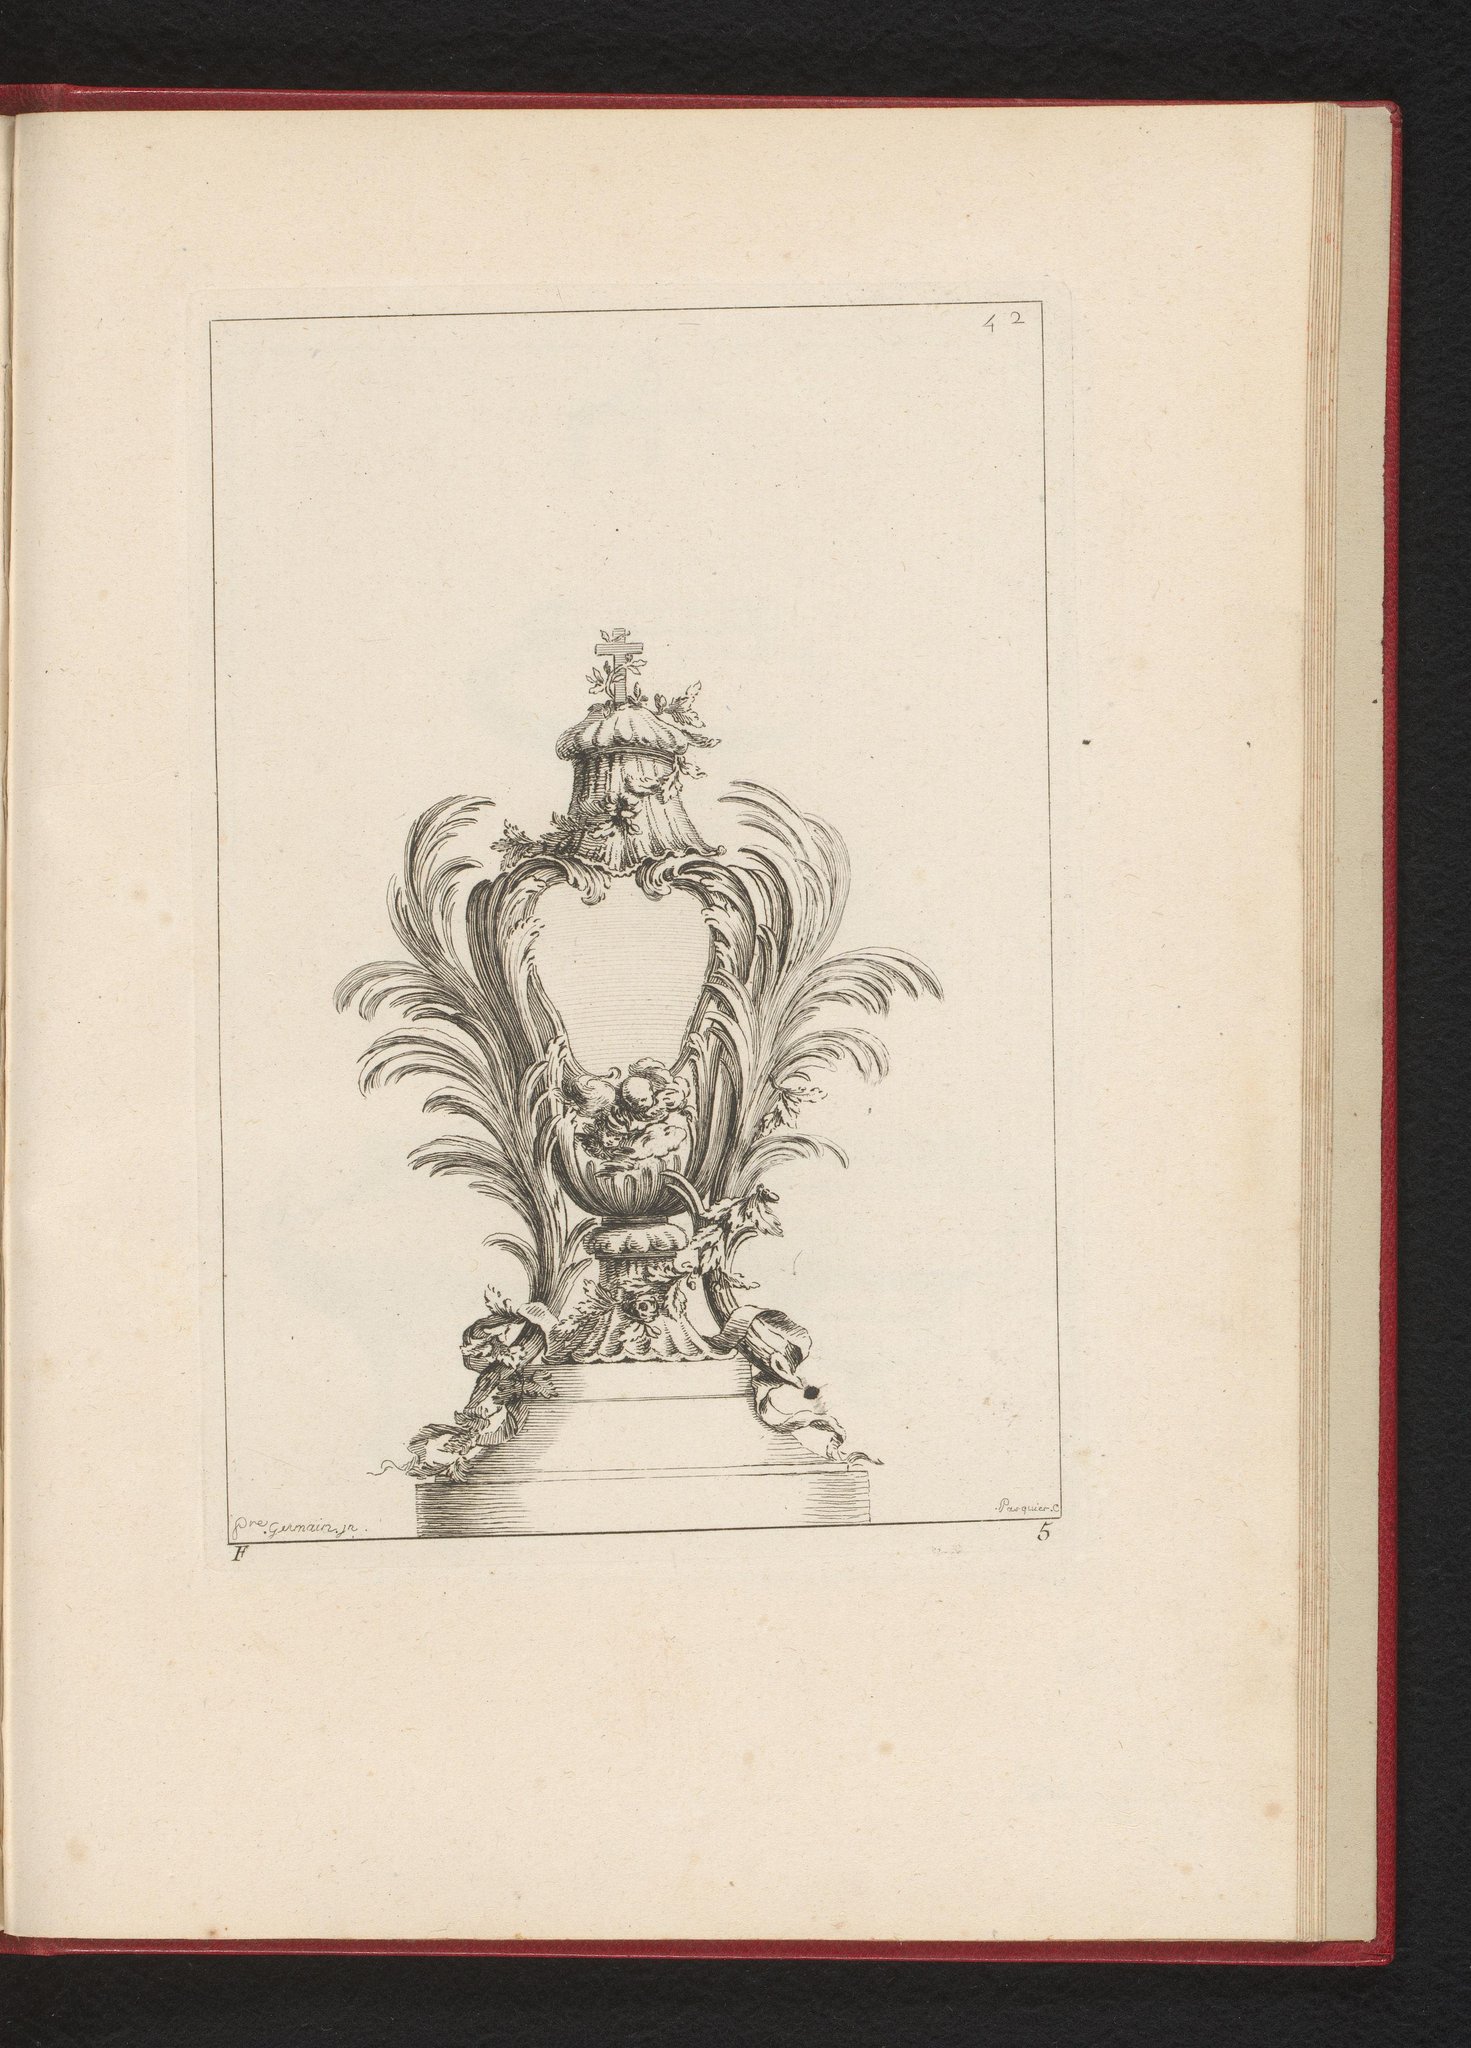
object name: album leaf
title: Ontwerp voor een reliekschrijn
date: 1748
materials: paper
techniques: etching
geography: paris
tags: relics (and reliquaries), jeweller, goldsmith, silversmith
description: Deze prent maakt deel uit van een album.